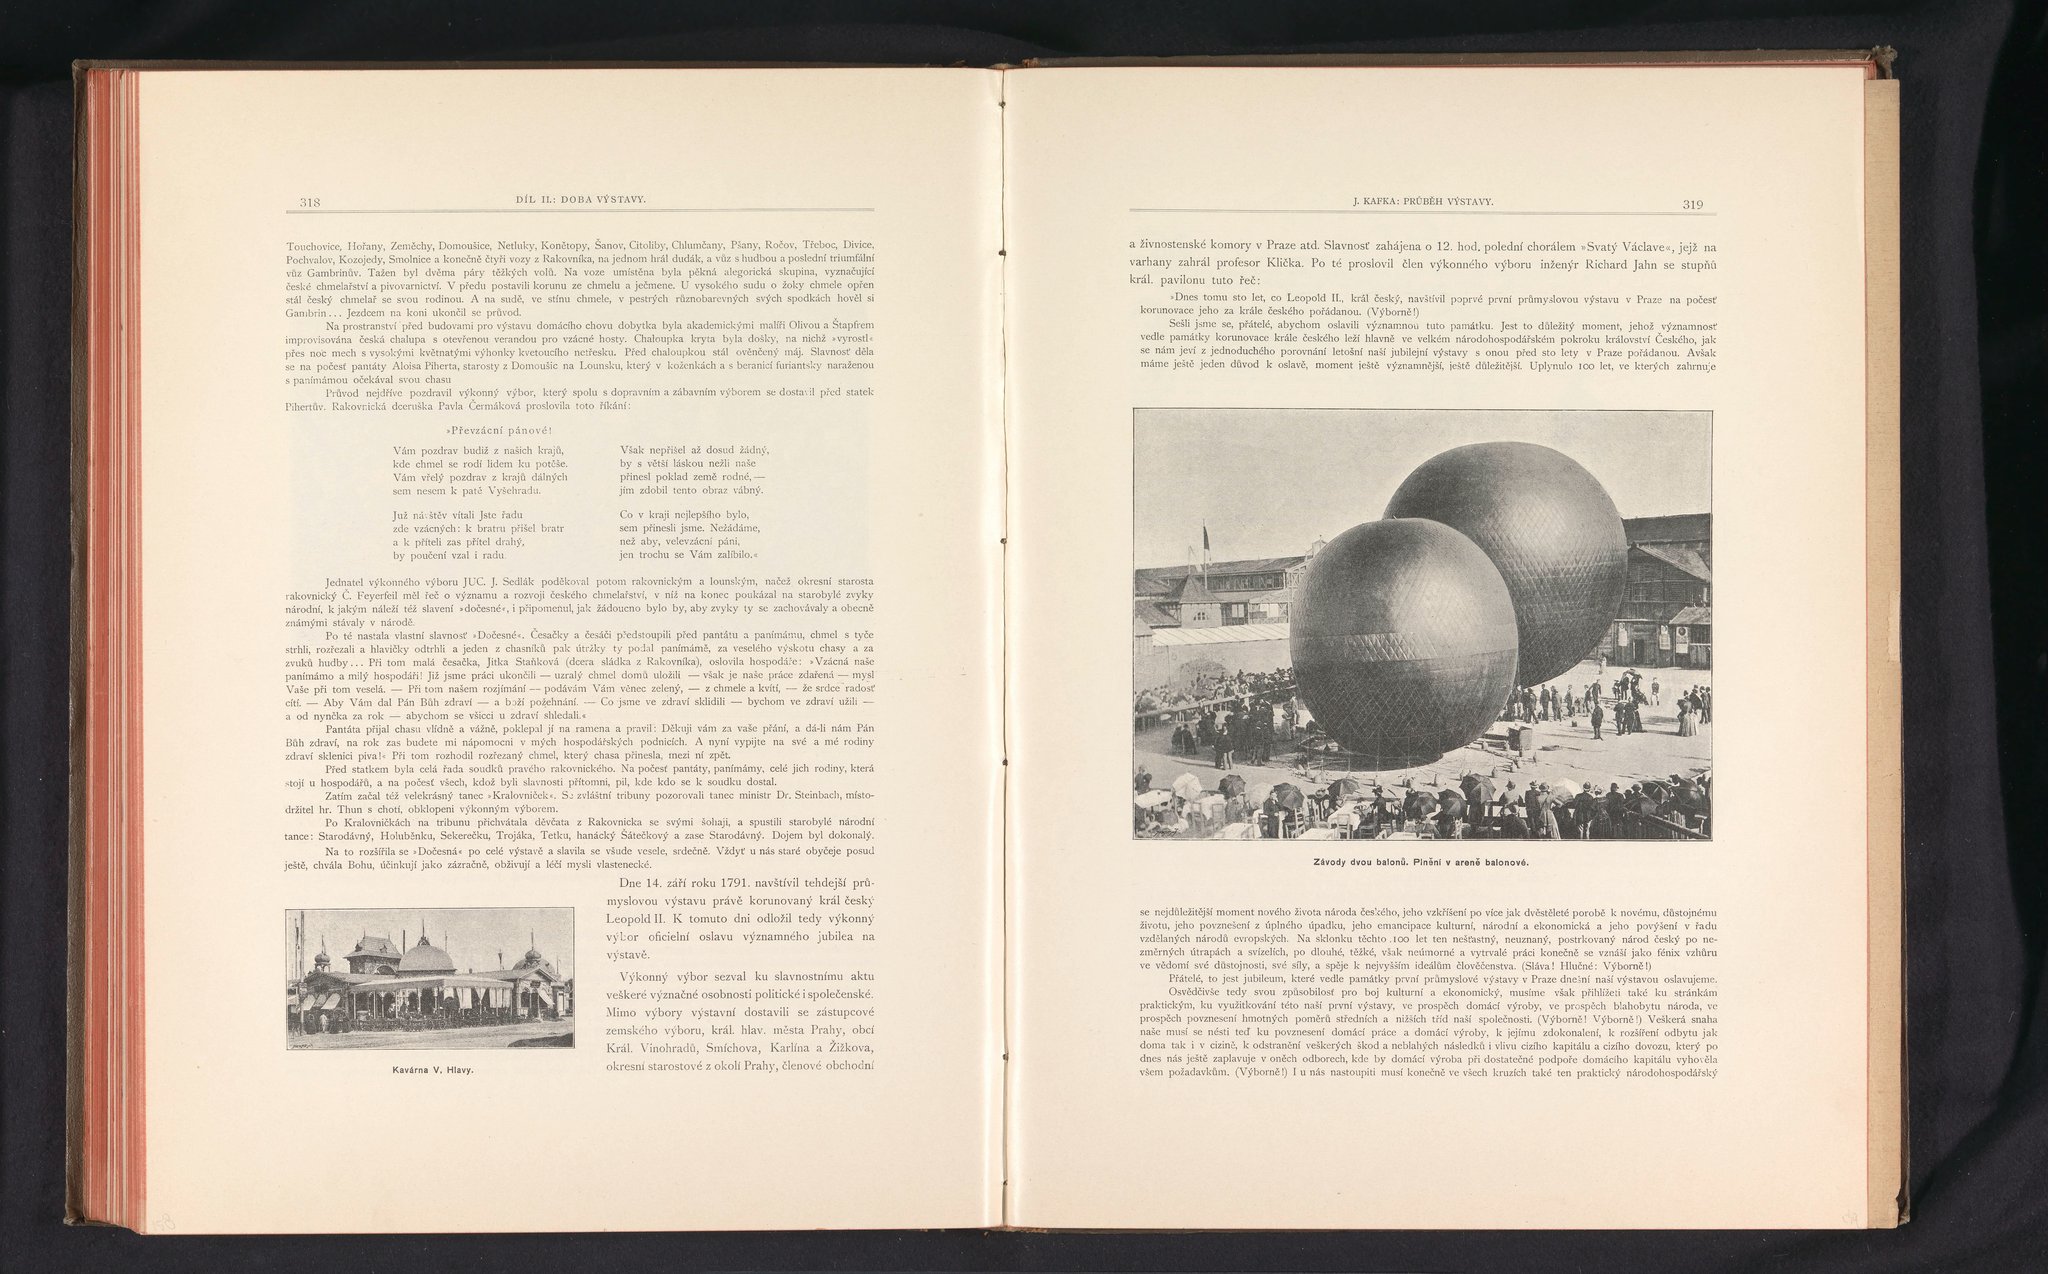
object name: page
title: Oplaten van twee luchtballonnen in een stadion te Praag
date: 1891-1893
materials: paper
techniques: autotype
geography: prague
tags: balloon (aviation)